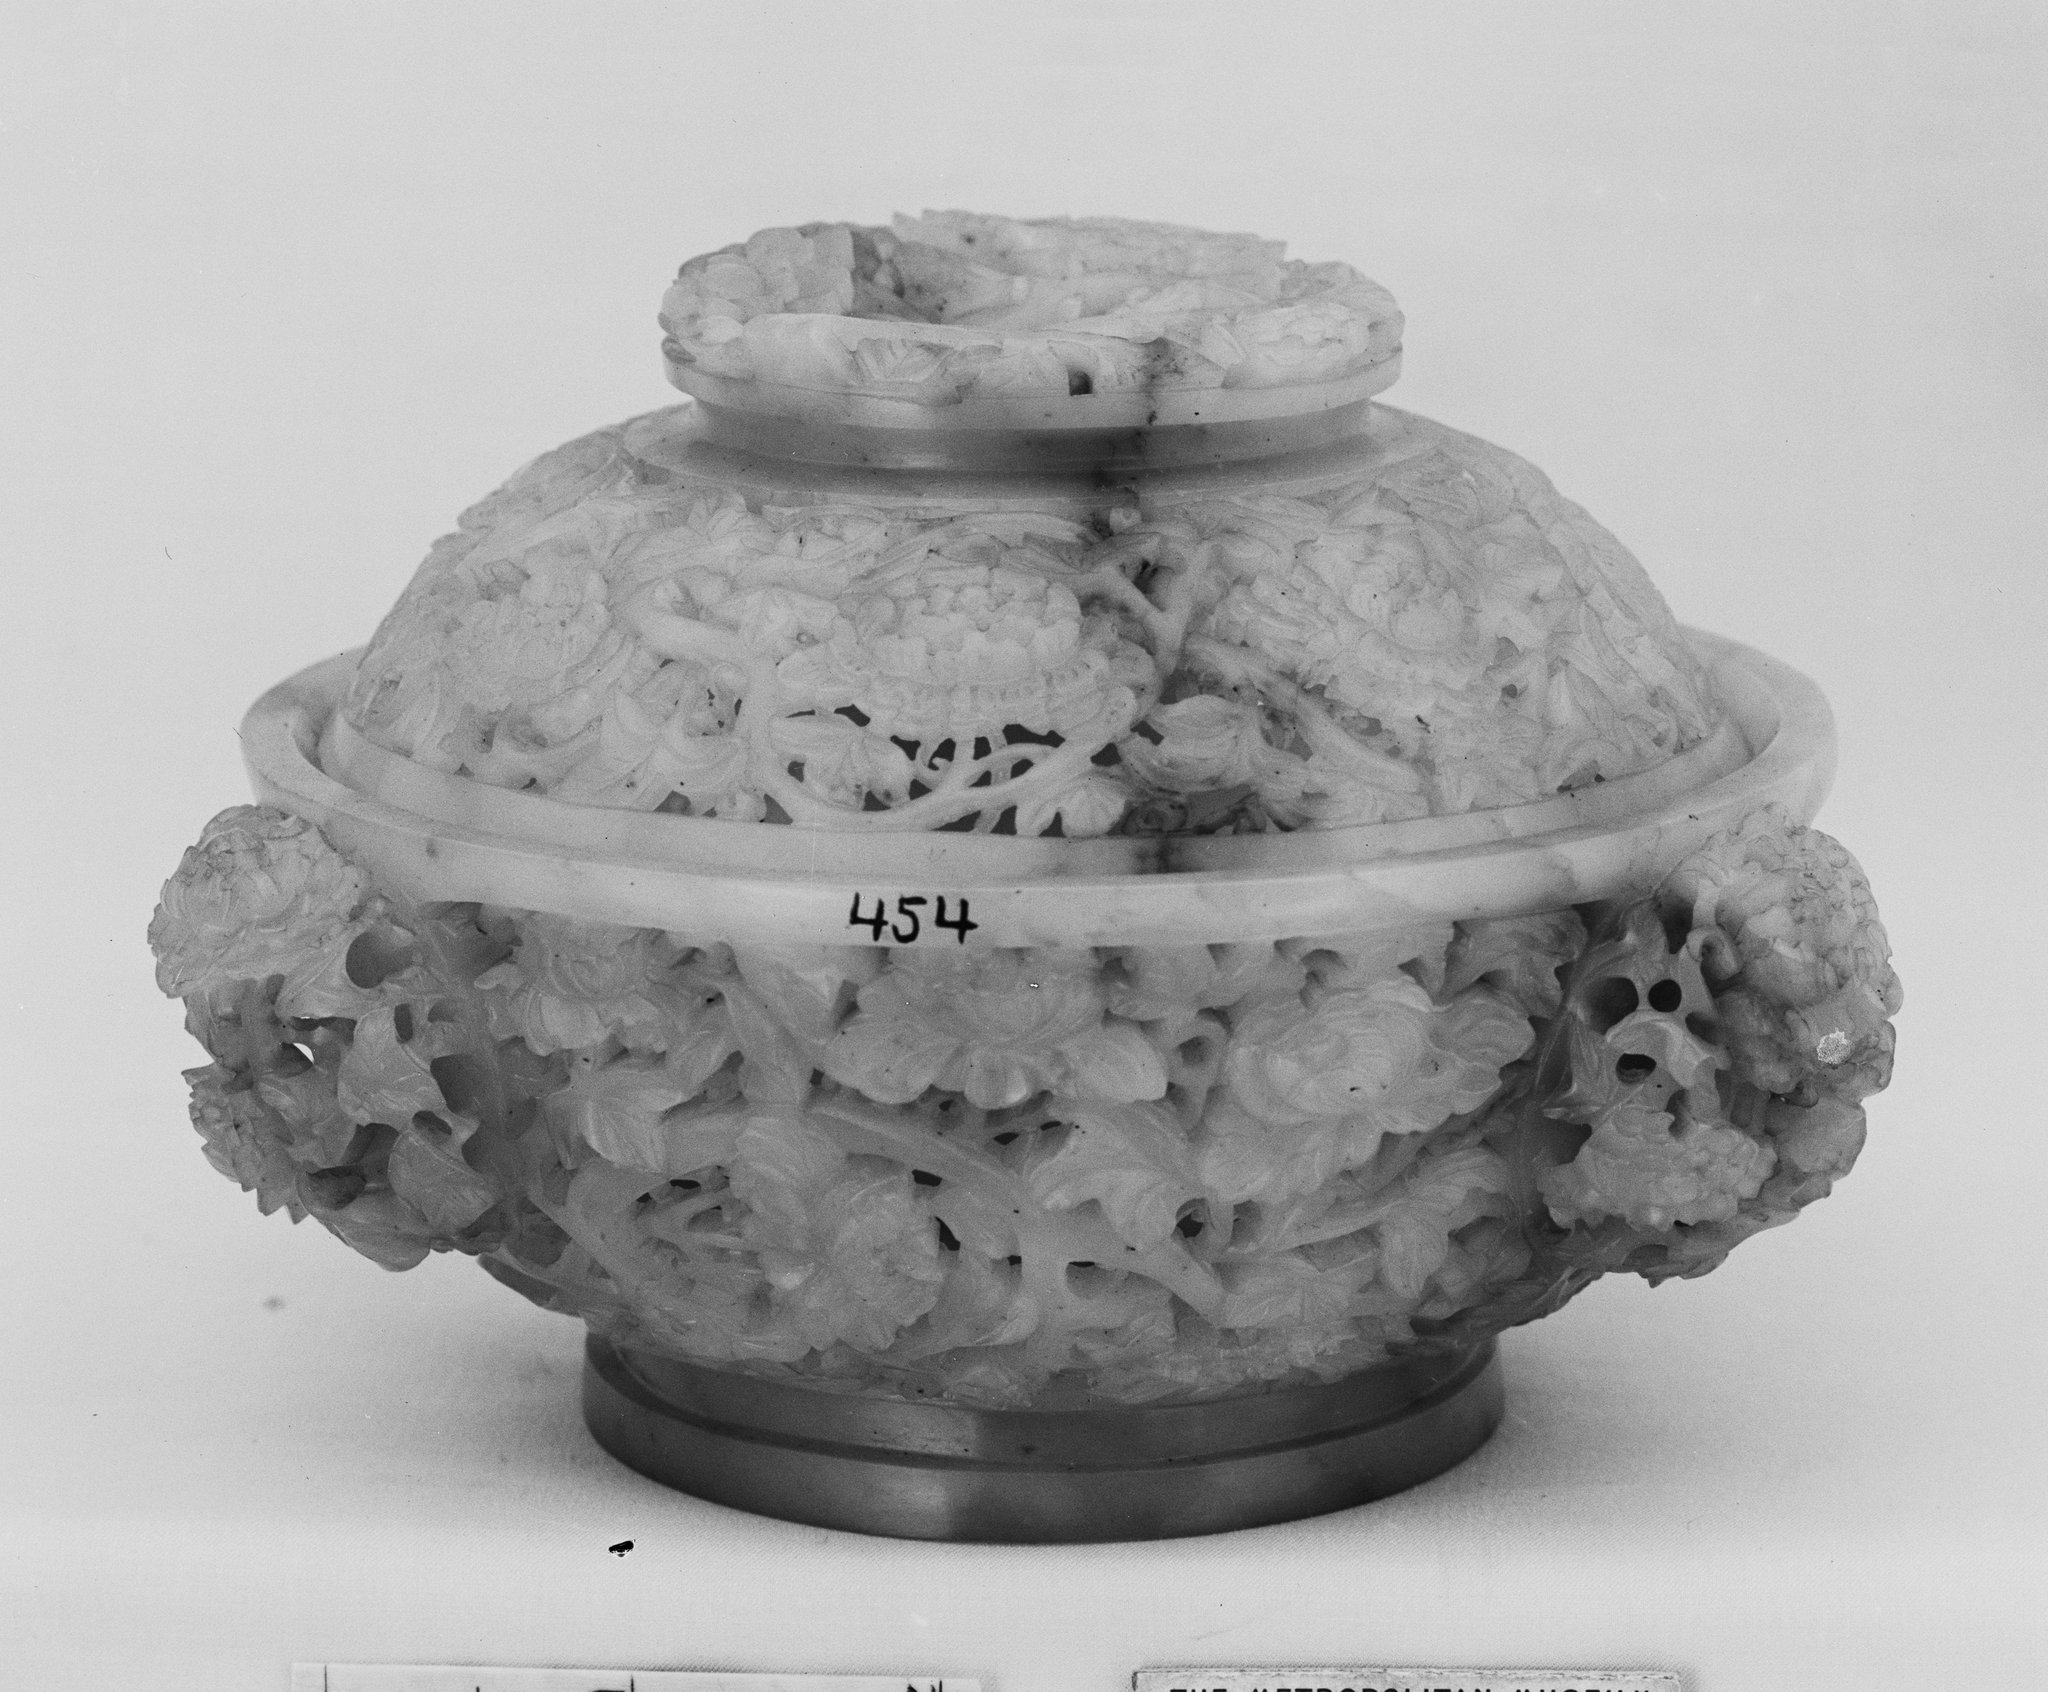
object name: incense burner with cover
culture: chinese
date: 1662-1722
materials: jade